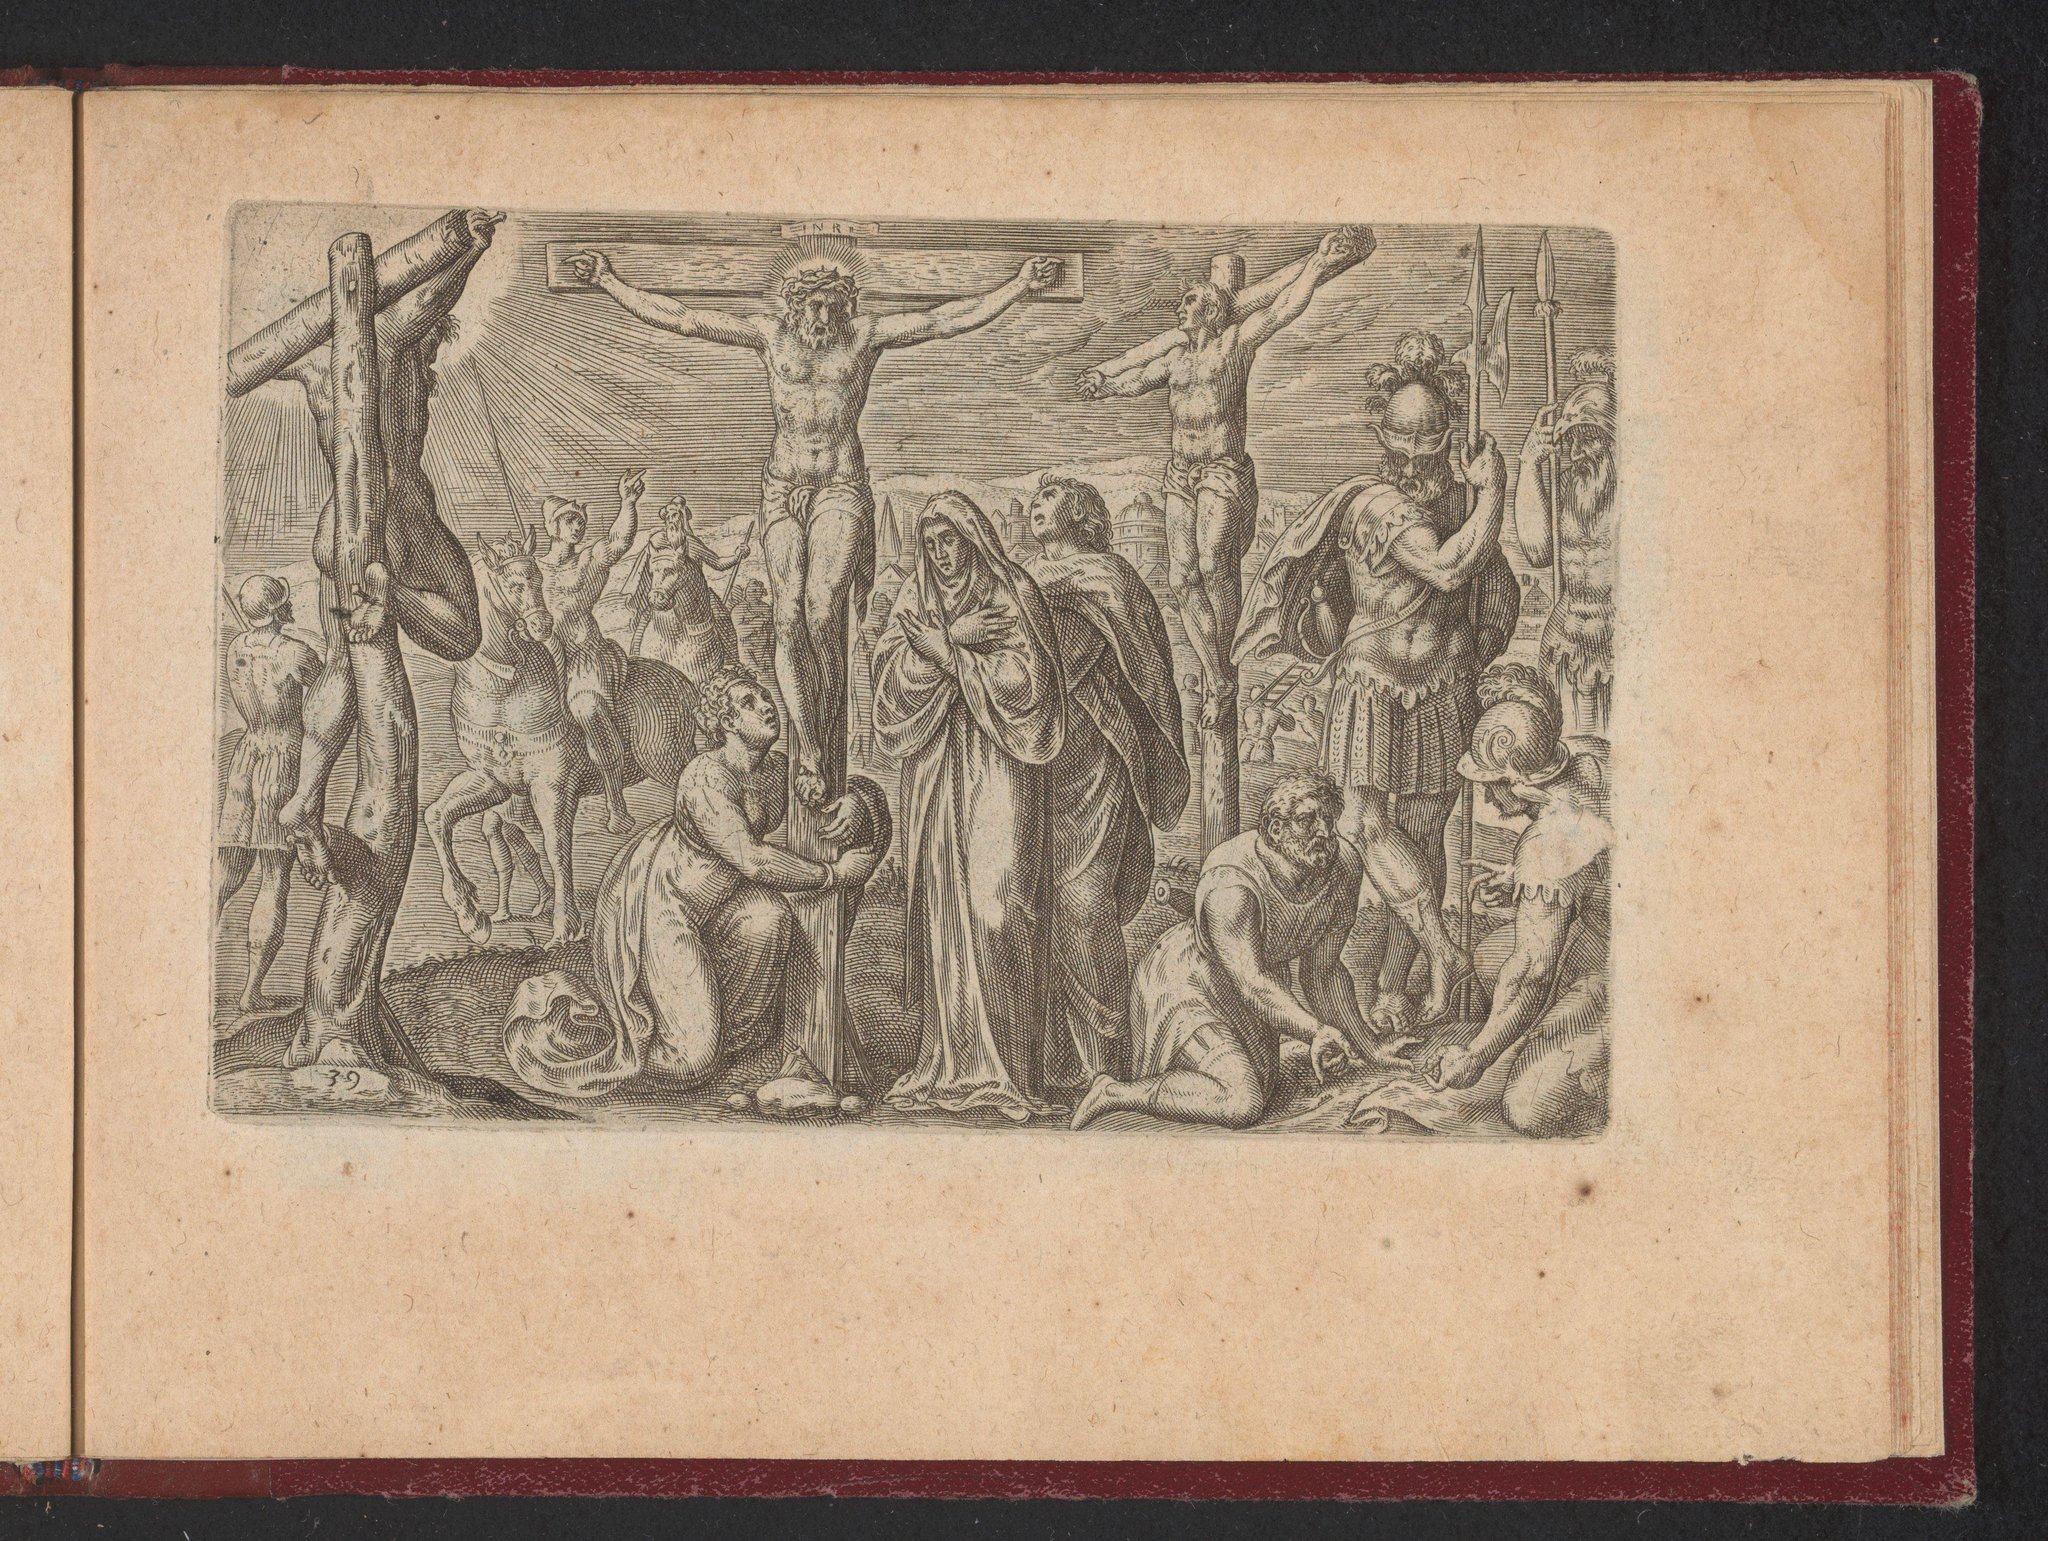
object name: print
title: Christi Iesu vitae admirabiliumque actionum speculum a Philippo Gallaeo apparatum Bened. Ariae Montani singuloribus distichis instructum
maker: philips galle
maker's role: print maker, publisher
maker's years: 1537-1612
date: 1573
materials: paper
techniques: engraving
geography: antwerp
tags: soldiers throwing dice for christ's seamless garment ~ christ's death on the cross, bystanders at the foot of the cross, among whom mary, mary magdalene and john the evangelist; mary may be shown swooning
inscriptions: watermark: ‘gotische letter P’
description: Onderdeel van een album met een titelprent en een serie van 50 prenten betreffende het leven en de passie van Christus.